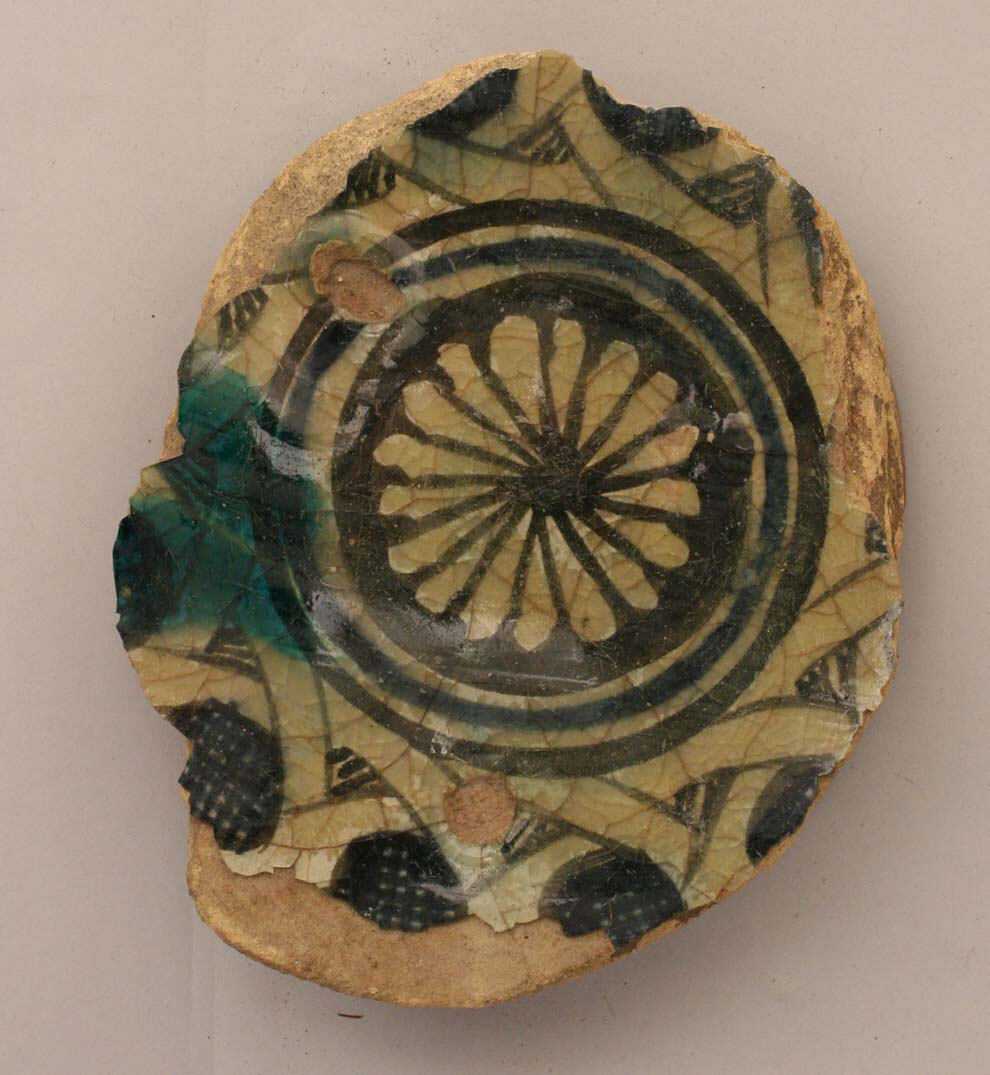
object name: ceramic fragment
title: Fragment of a Dish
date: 1401-1500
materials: glaze, stonepaste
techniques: painting, polychrome, underglaze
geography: egypt